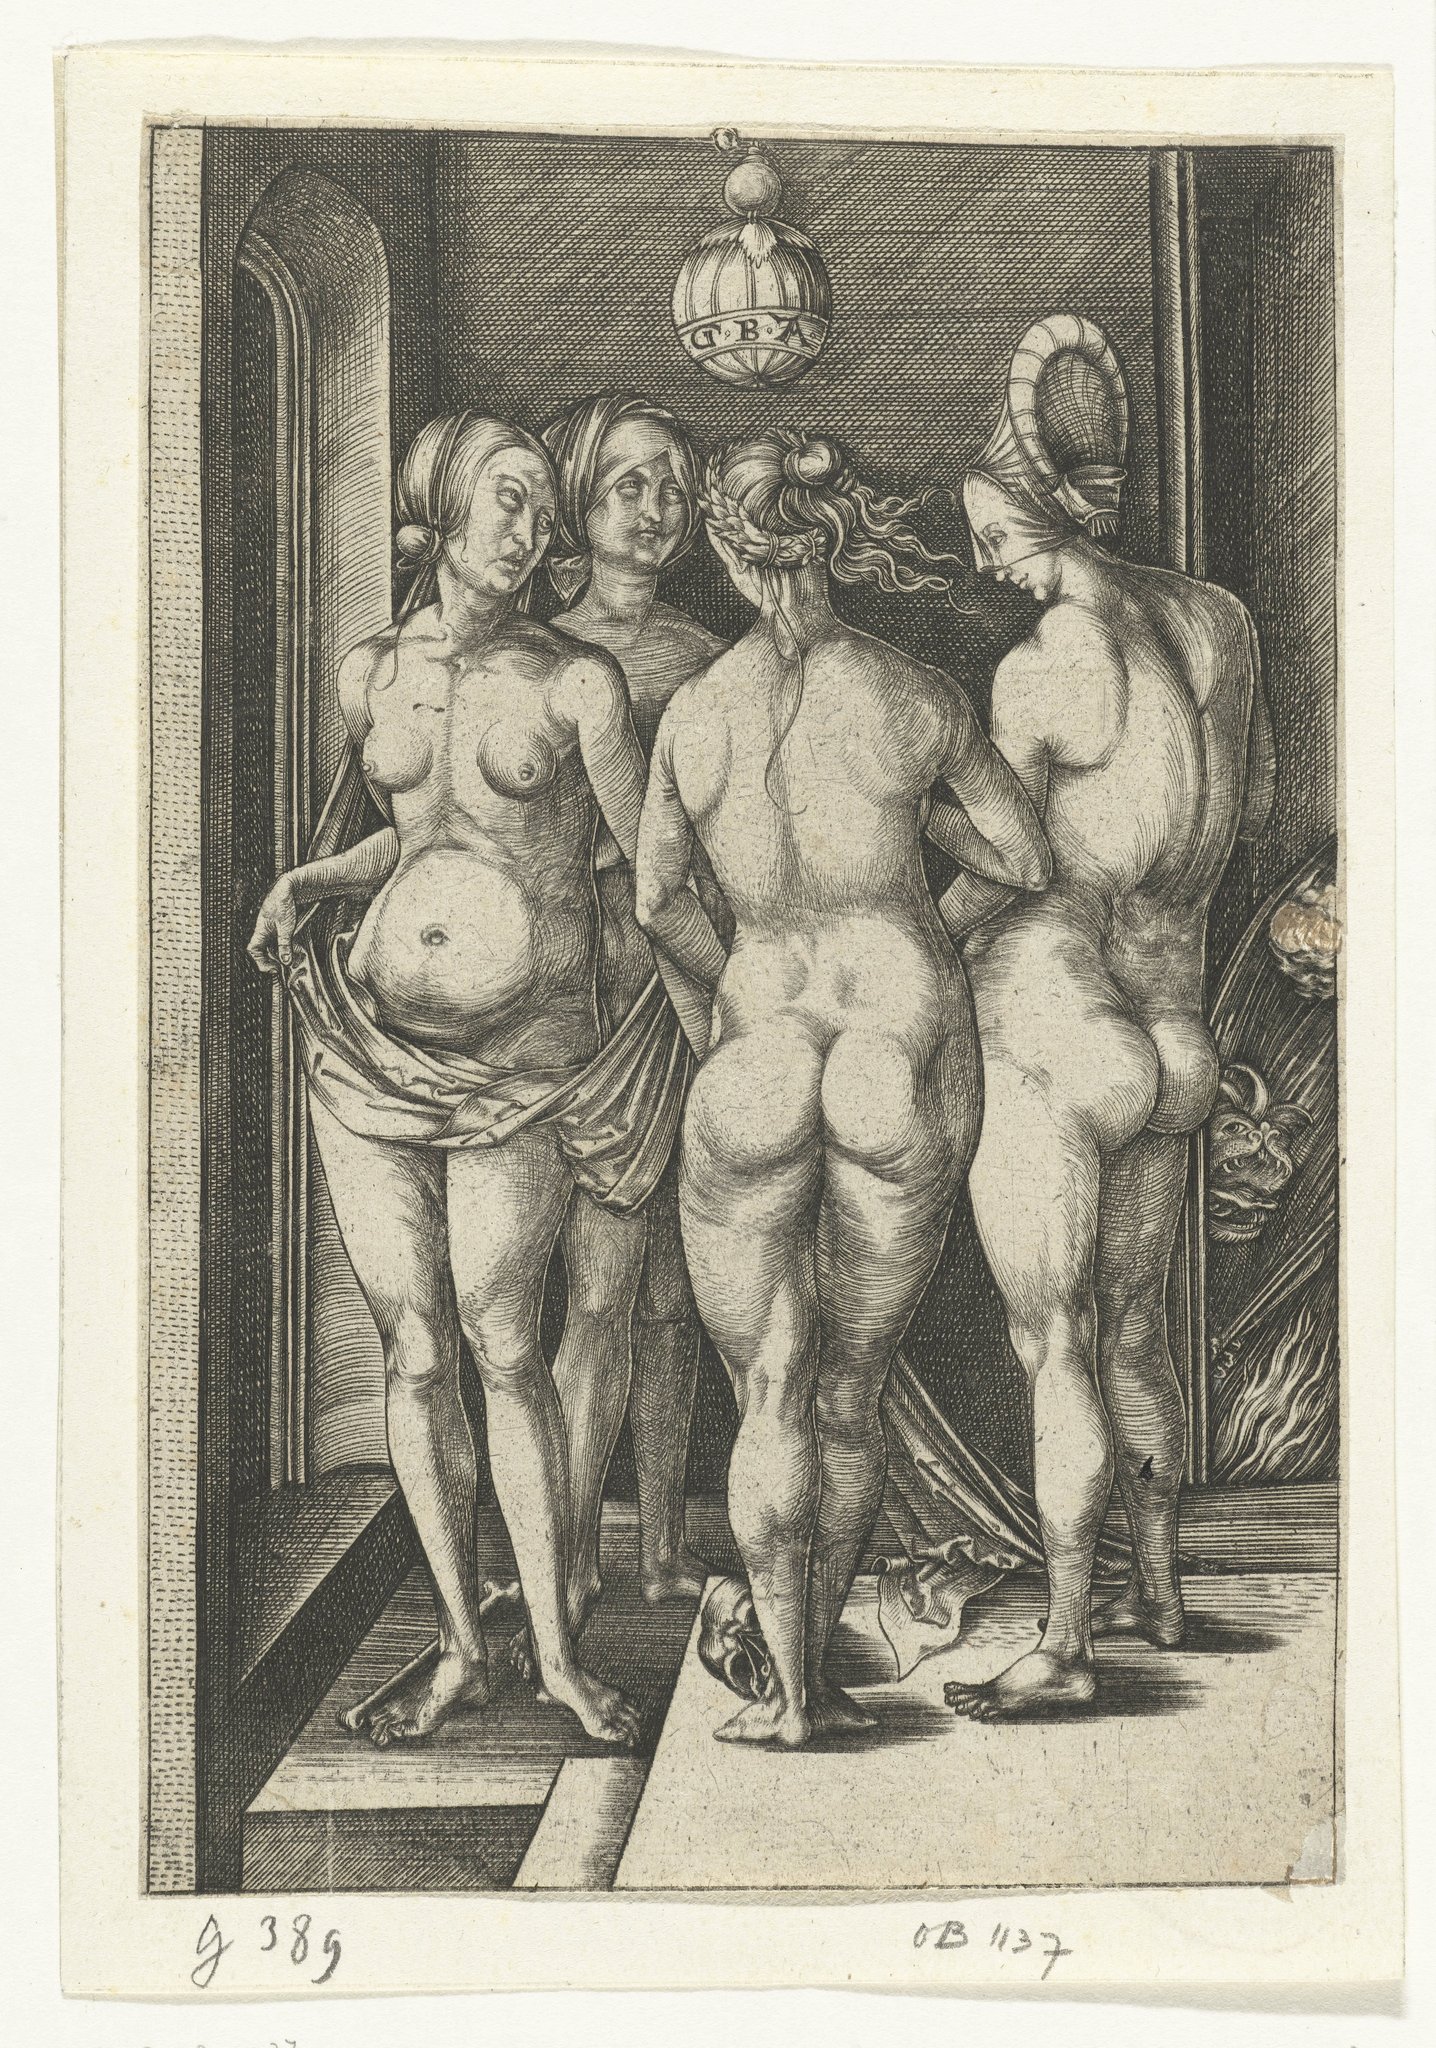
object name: print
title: Vier naakte vrouwen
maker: israhel van meckenem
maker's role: print maker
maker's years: 1440-1517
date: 1455-1503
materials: paper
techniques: engraving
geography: bocholt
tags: devils in the form of (fabulous) animals, sphere, globe ~ stereometry, head-gear (+ women's clothes), groups of witches, standing figure - aa - female human figure (+ back view), standing figure - aa - female human figure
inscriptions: collector's mark: Lugt 240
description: Vier naakte vrouwen staan in een vertrek nabij een lage poort waardoor vuur en een duivels monster te zien zijn. Boven de hoofden van de vrouwen hangt een bol waarop de letters GBA staan.